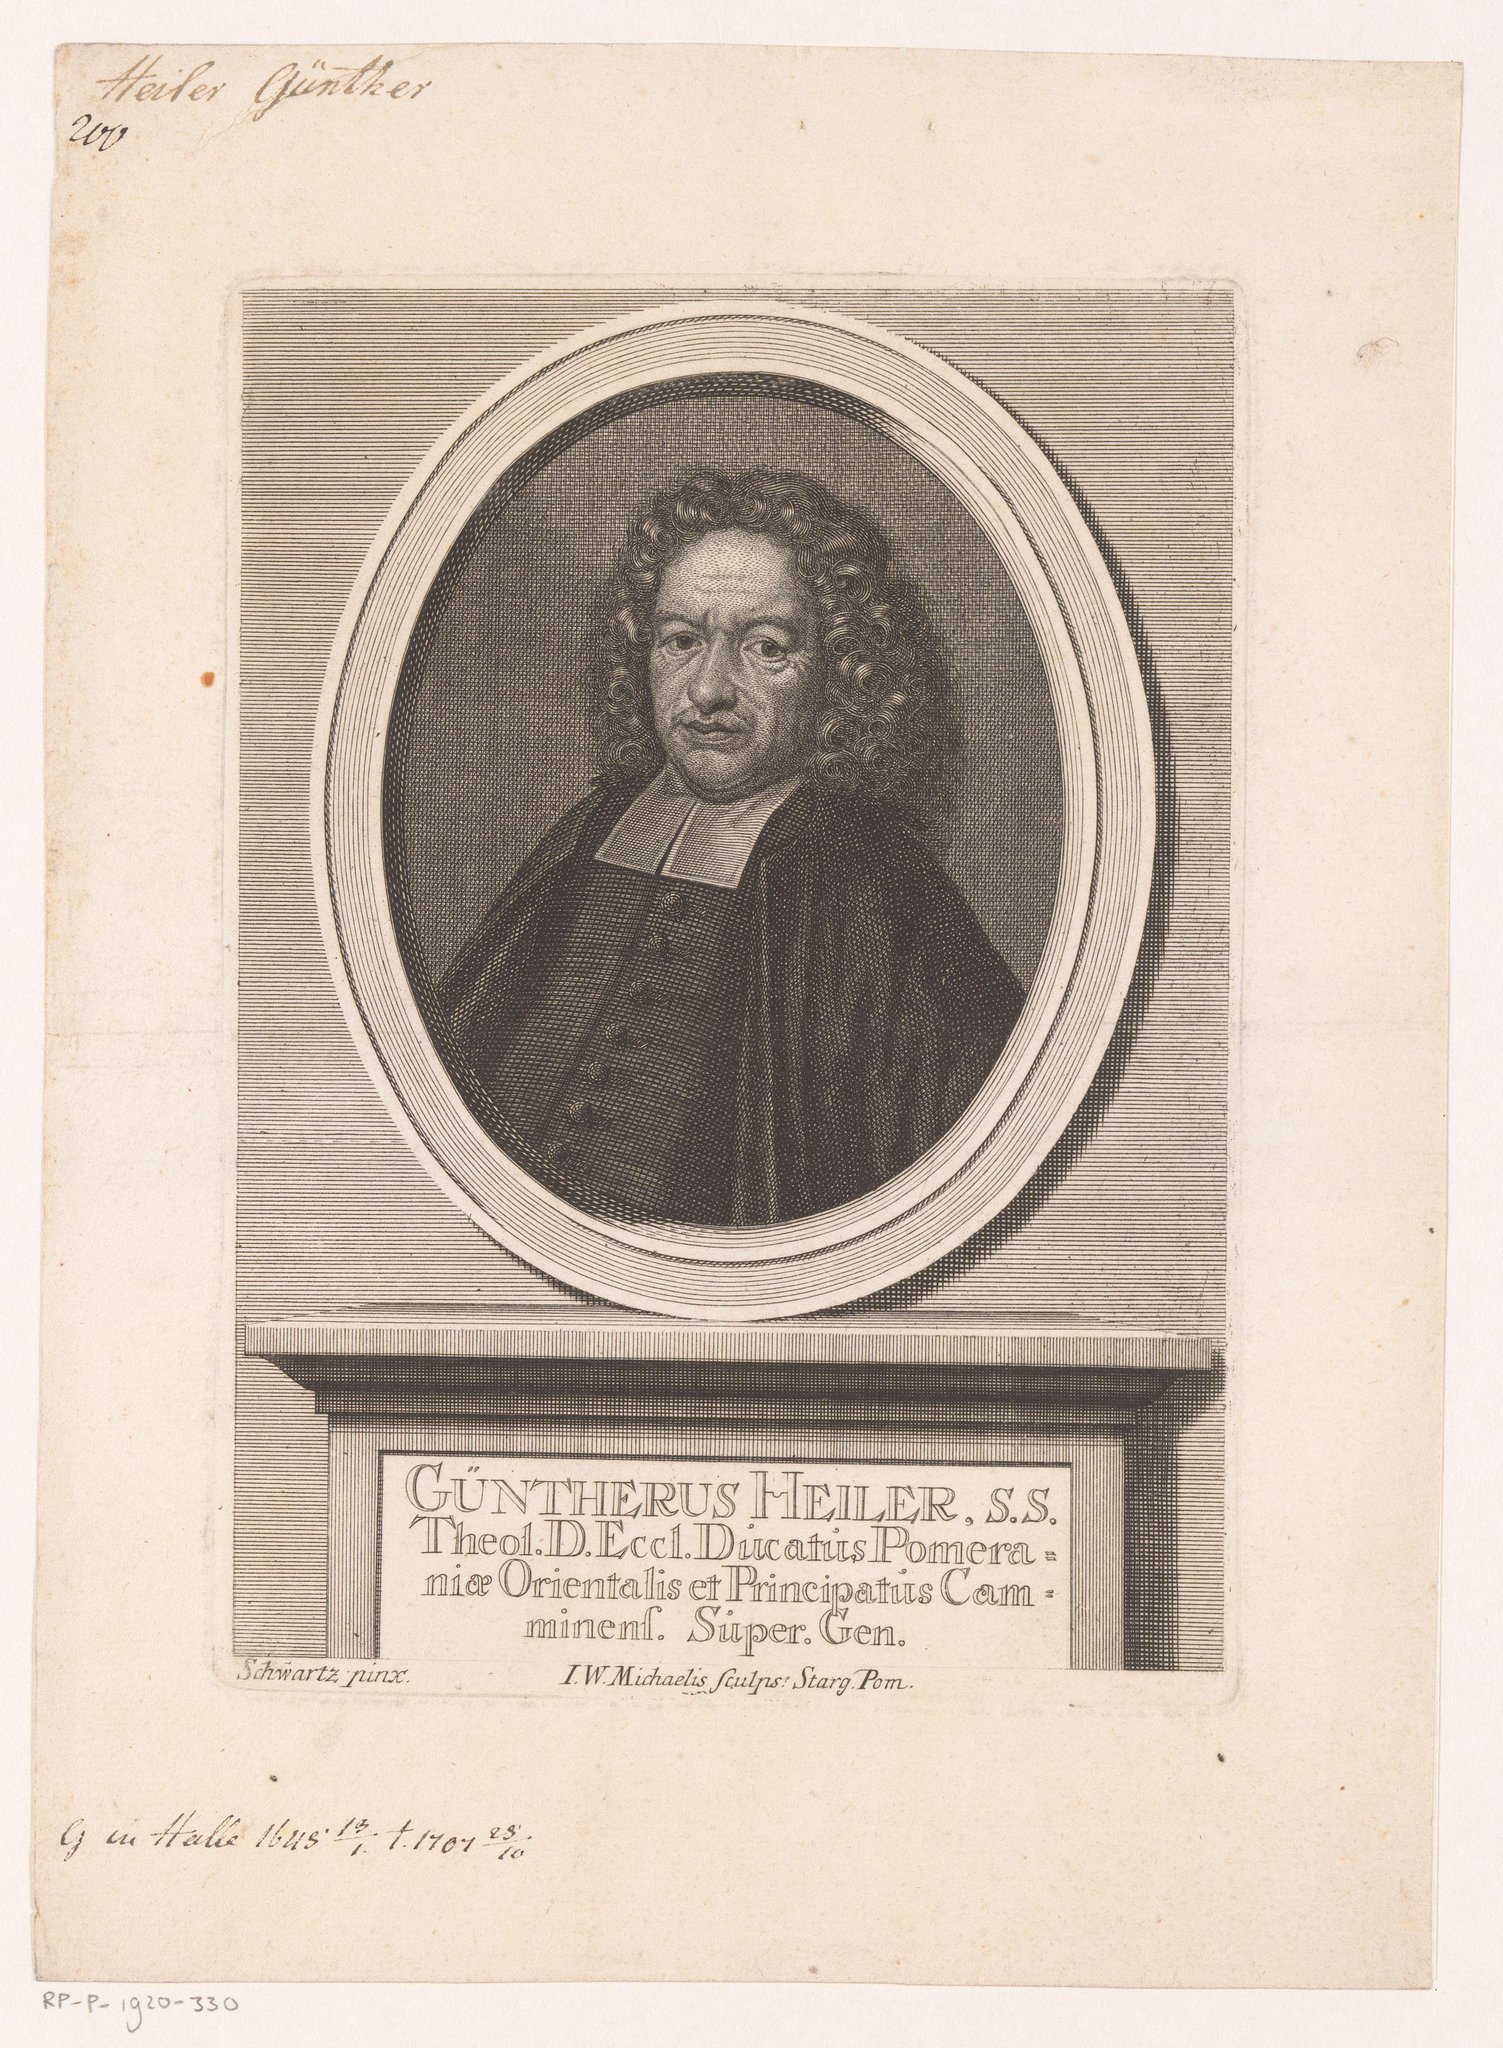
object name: print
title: Portret van Günther Heiler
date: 1675-1737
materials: paper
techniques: engraving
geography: stargard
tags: historical persons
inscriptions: collector's mark: Lugt 2228, number: ‘200’